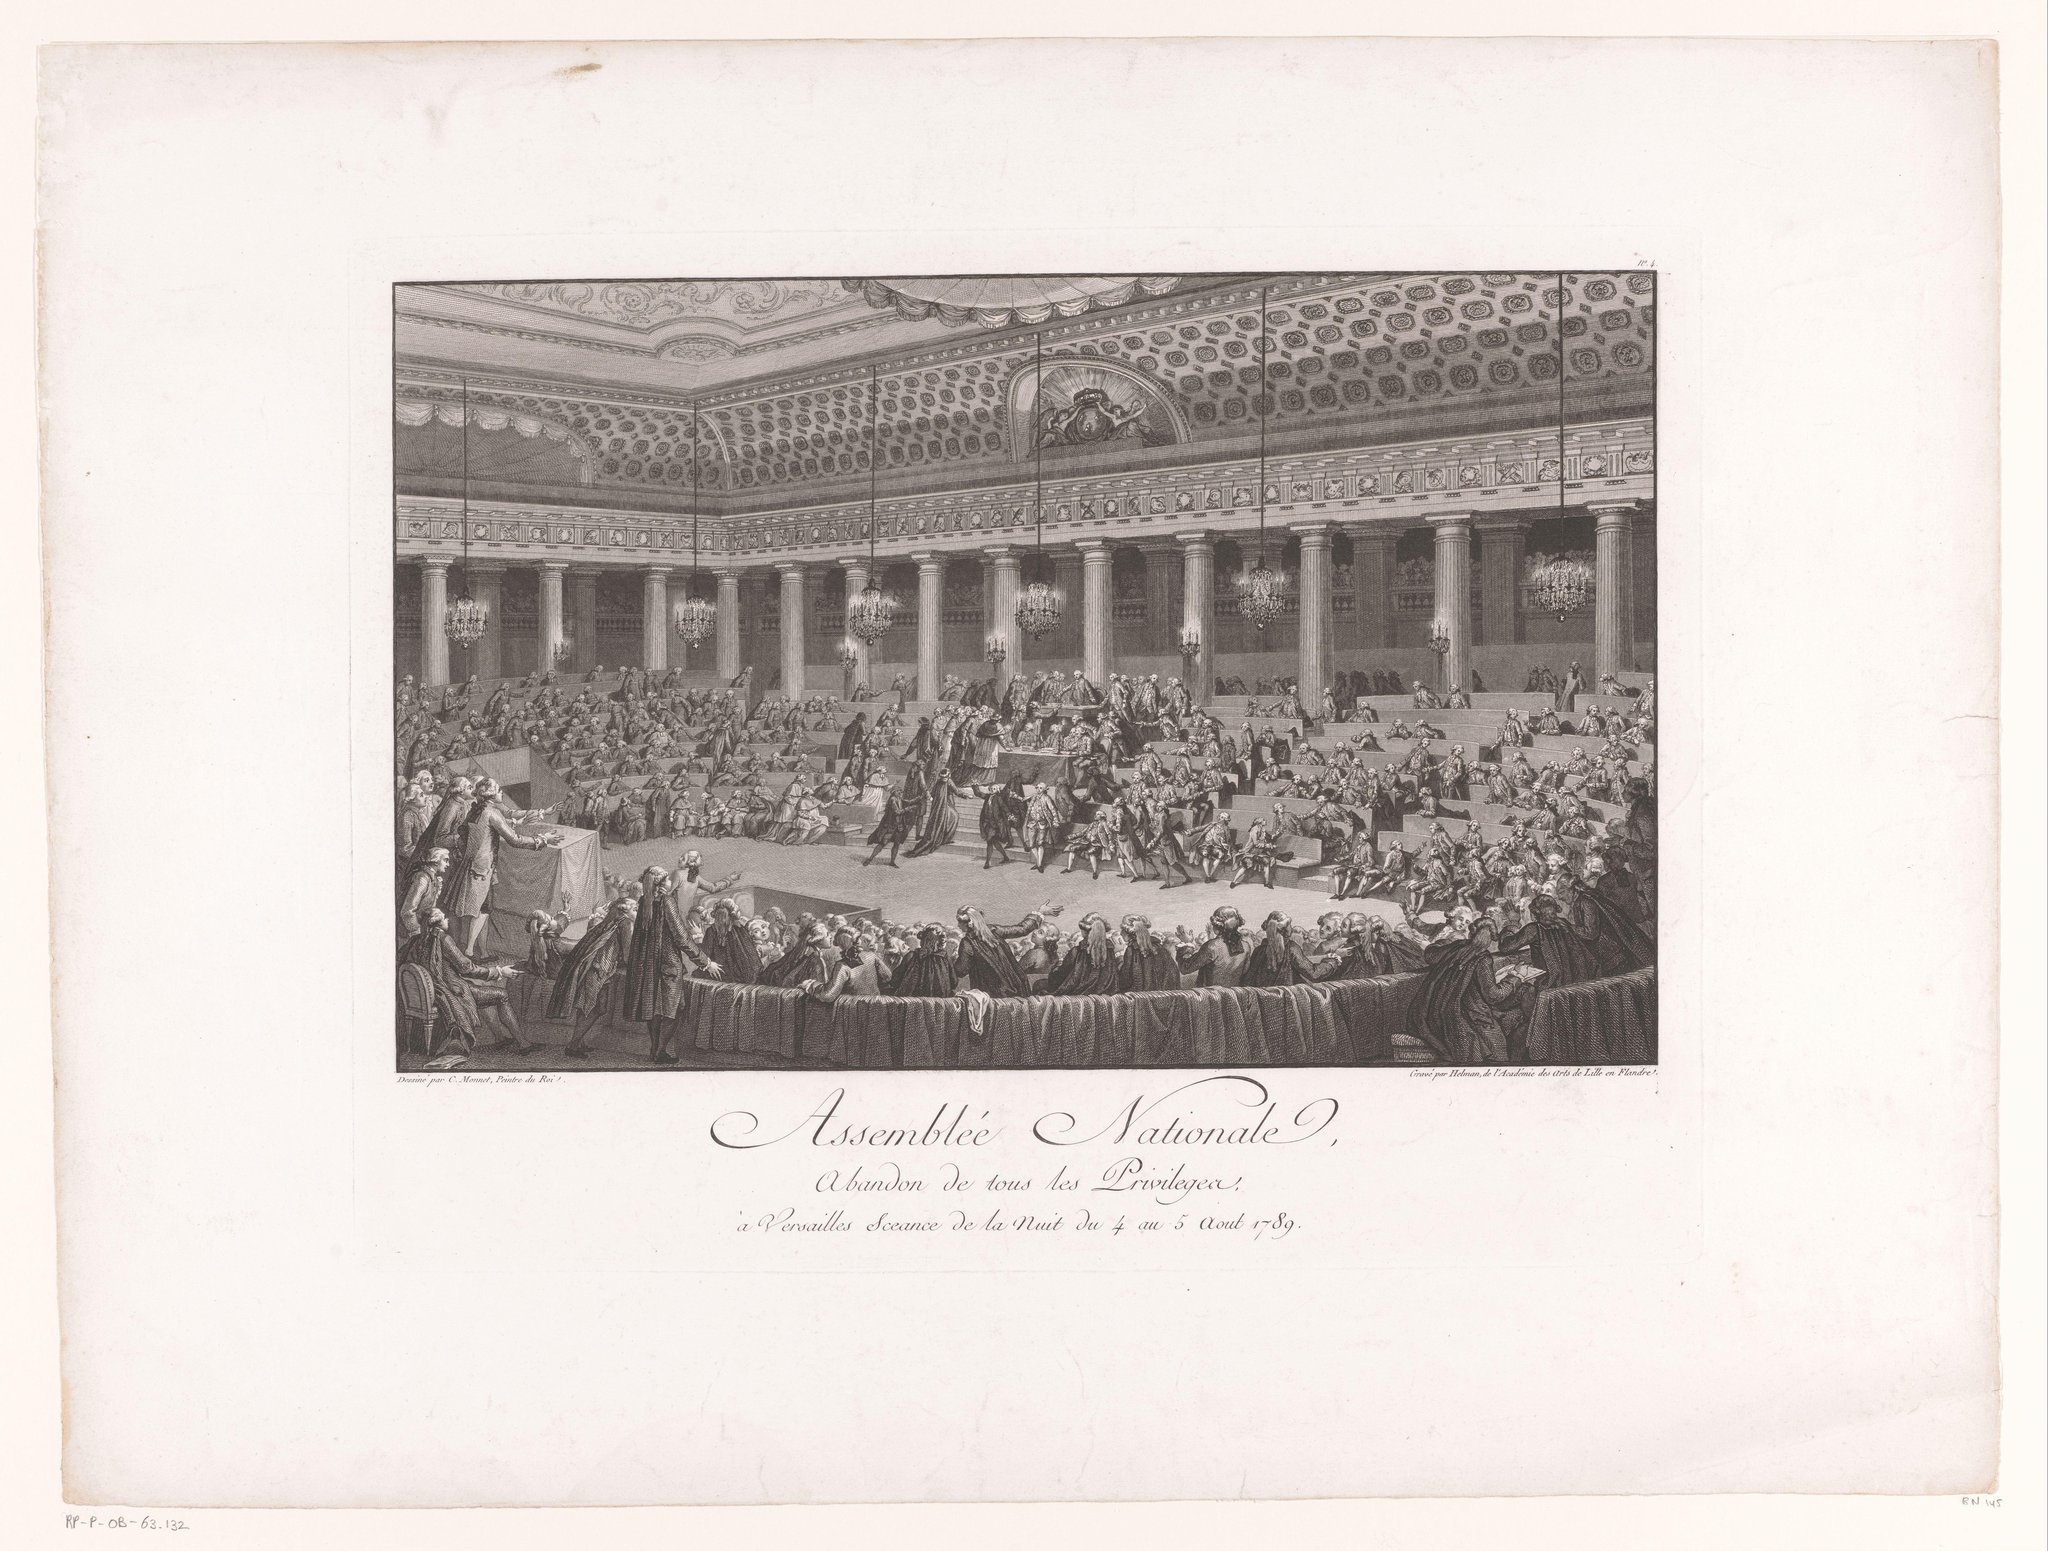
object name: print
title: Eerste dagen van de Franse Revolutie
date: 1793-1806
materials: paper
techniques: engraving, etching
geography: france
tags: meeting, assembly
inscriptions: collector's mark: Lugt 2228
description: Maakt deel uit van een serie getiteld 'La Révolution française depuis l'ouverture des États géneraux jusquáu 9 Brumaire' met vijftien prenten naar schilderijen met als onderwerp de eerste dagen van de Franse Revolutie. De serie werd verschillende malen uitgegeven, aanvankelijk onder de titel 'Les principales journées de la Révolution'. Voor meer informatie zie IFF 18e siècle, dl. 11, p. 291.